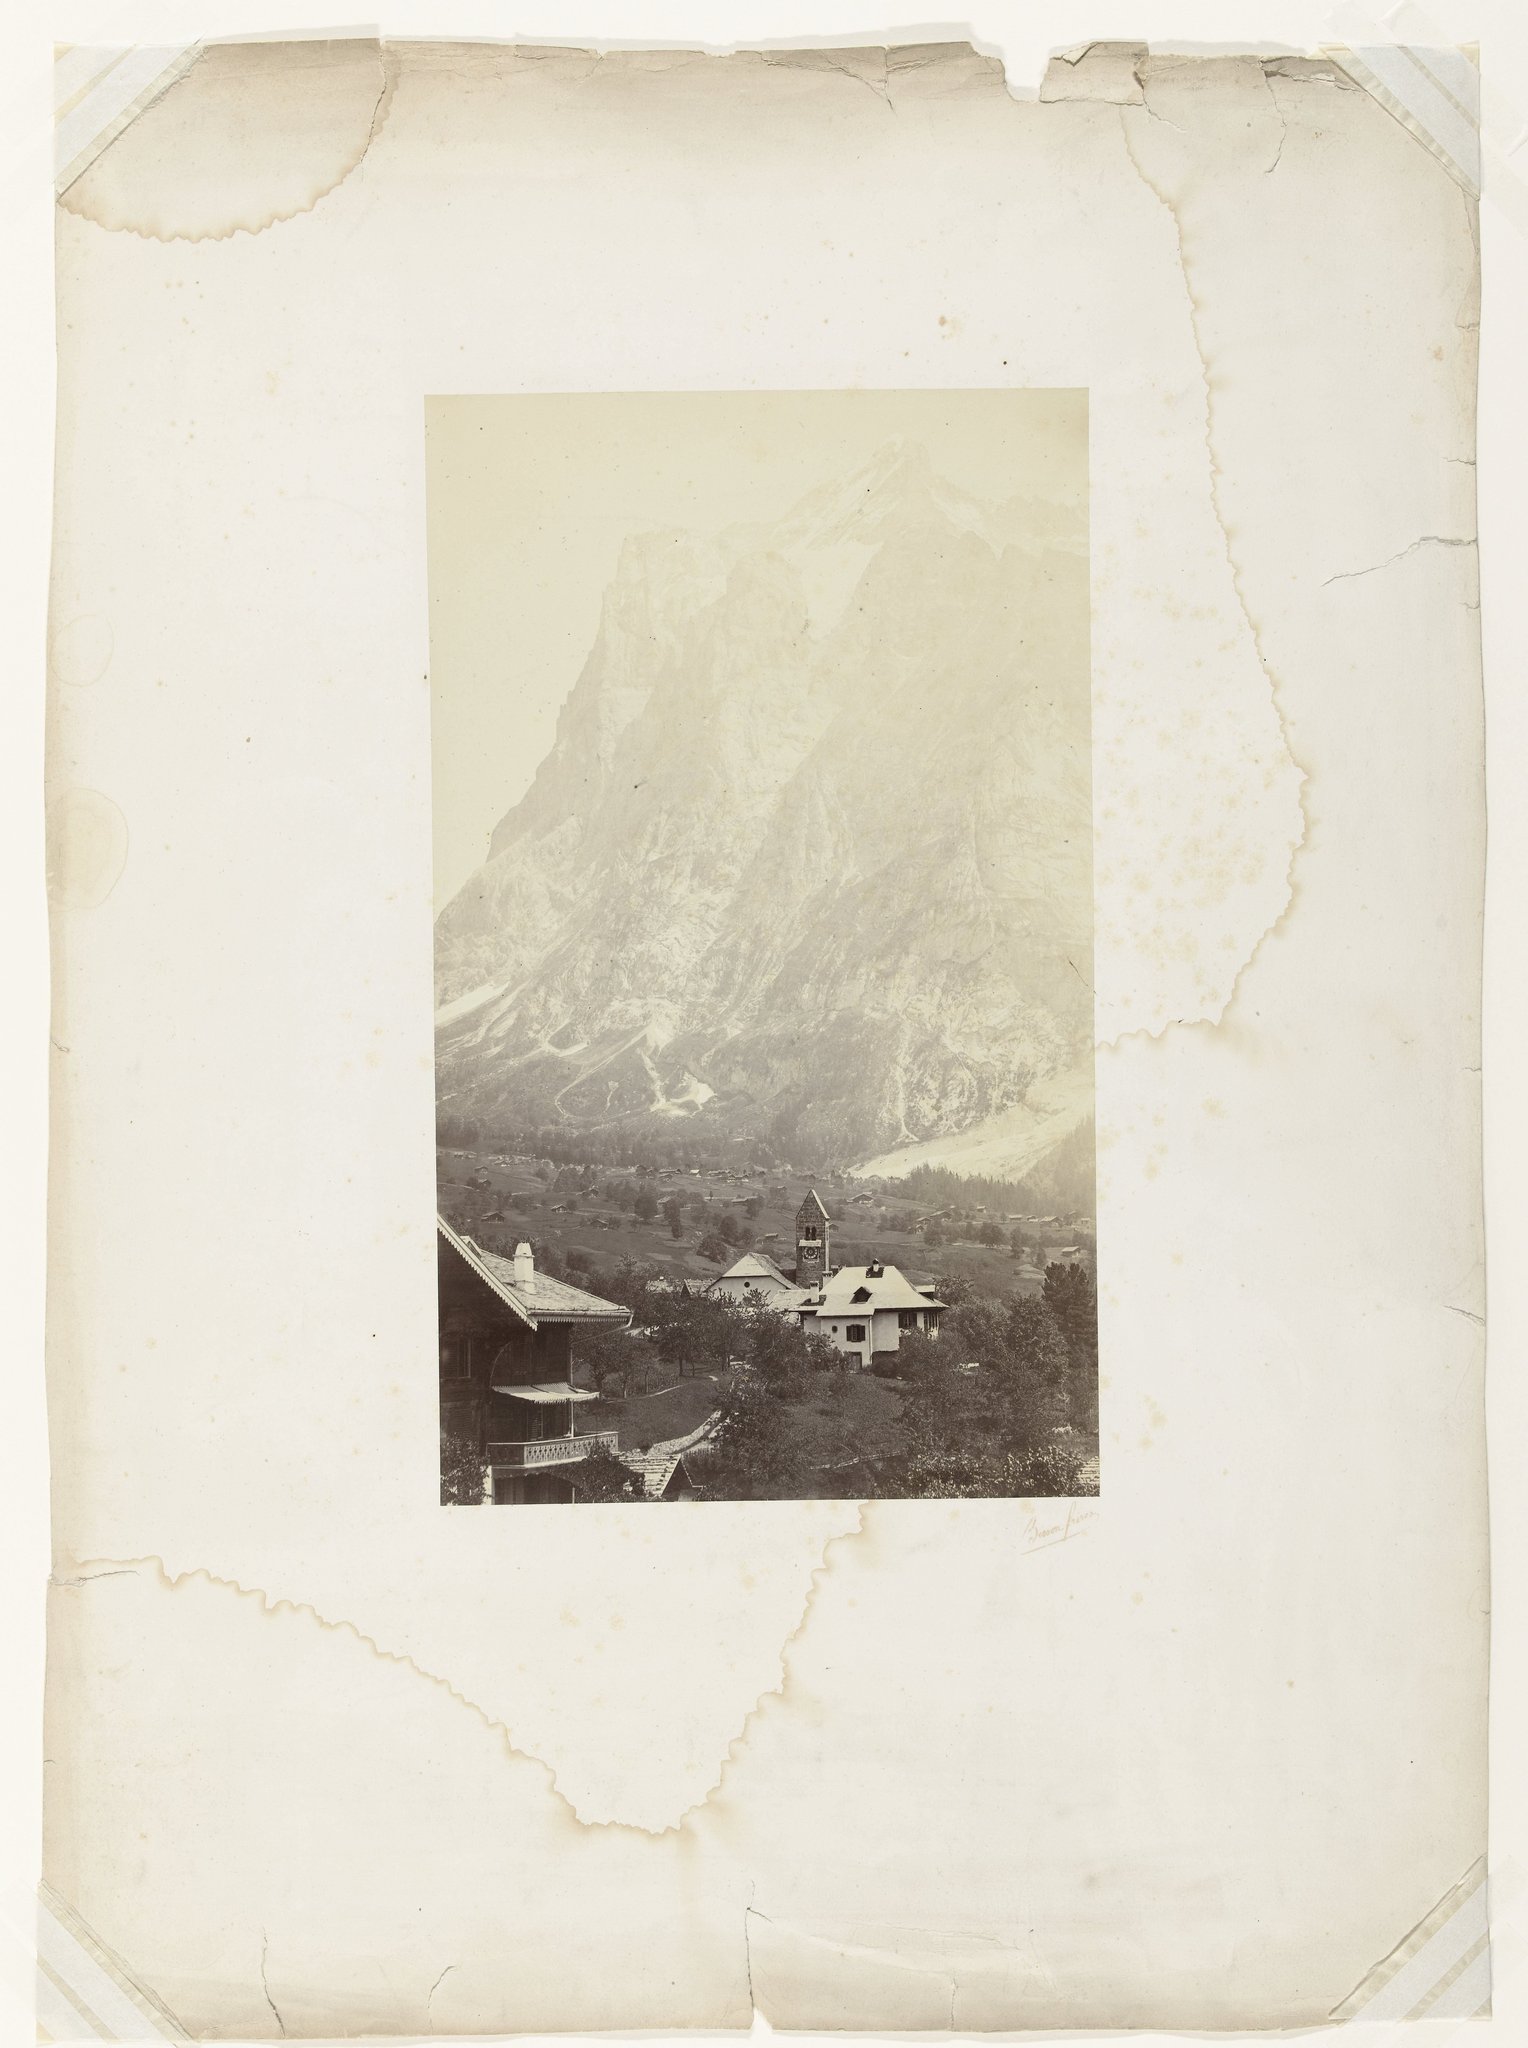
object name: photograph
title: Alpenlandschap met een dorpje op de voorgrond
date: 1859-1862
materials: cardboard, photographic support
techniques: albumen print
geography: france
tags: mountains